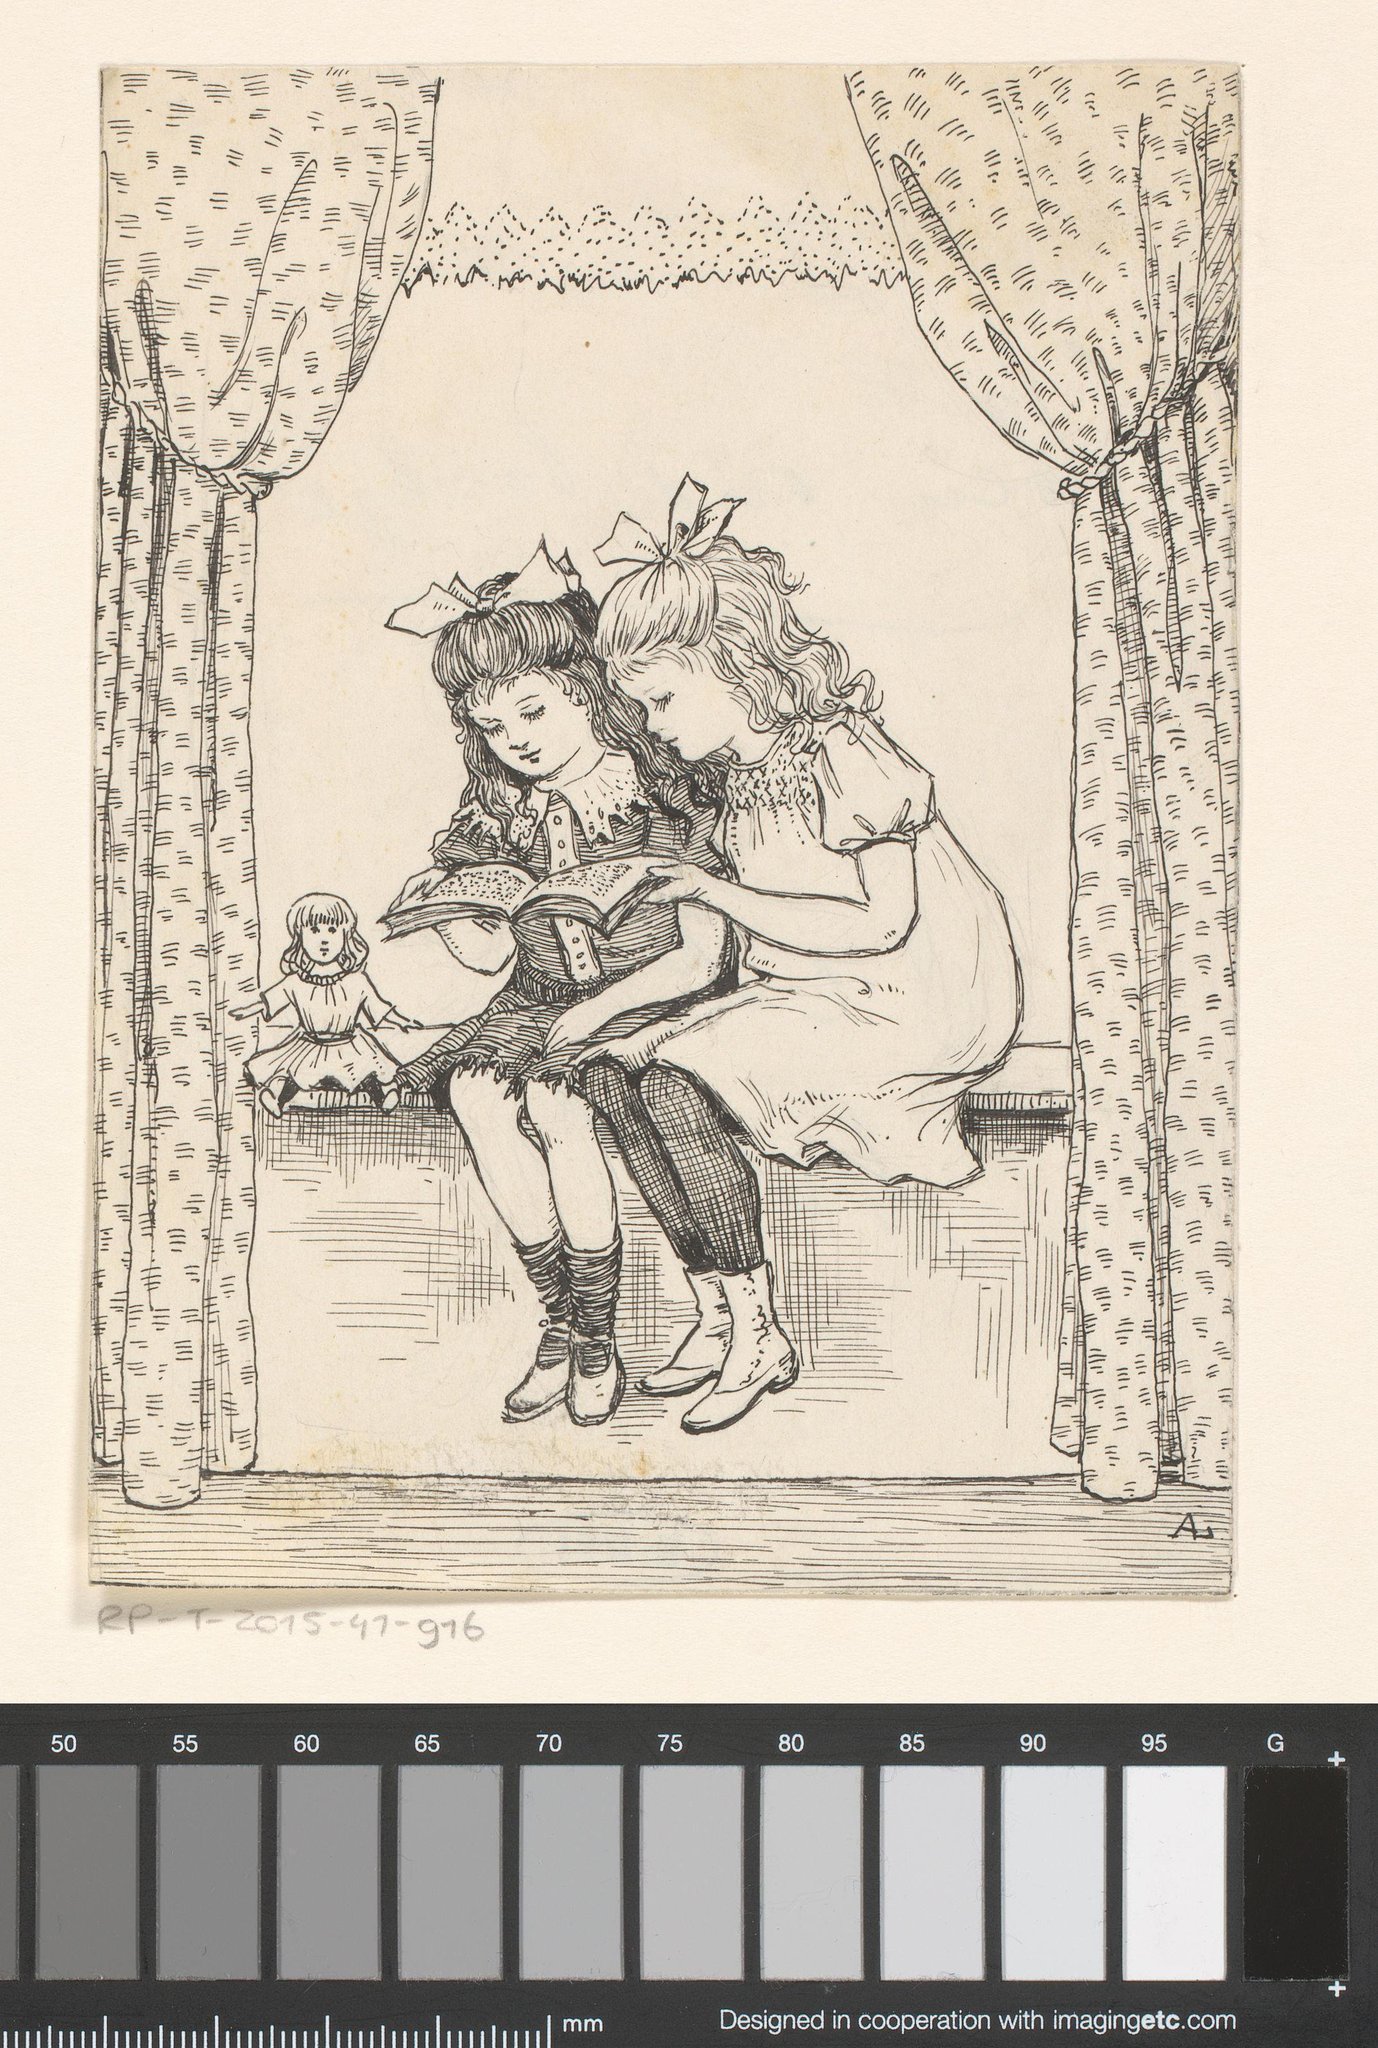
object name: boekillustratie ontwerp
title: Twee lezende meisjes in een vensterbank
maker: adri ladenius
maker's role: draughtsman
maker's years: 1883-1953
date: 1893-1953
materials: ink, paper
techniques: pen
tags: window-seat, reading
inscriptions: signature: ‘AL’, annotation: ‘I/ Een oud boekje’, collector's mark: Lugt 2228, :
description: Twee meisjes zitten in een vensterbank en lezen samen in één boek. De meisjes dragen strikken in het haar. Naast hen zit een pop in de vensterbank.